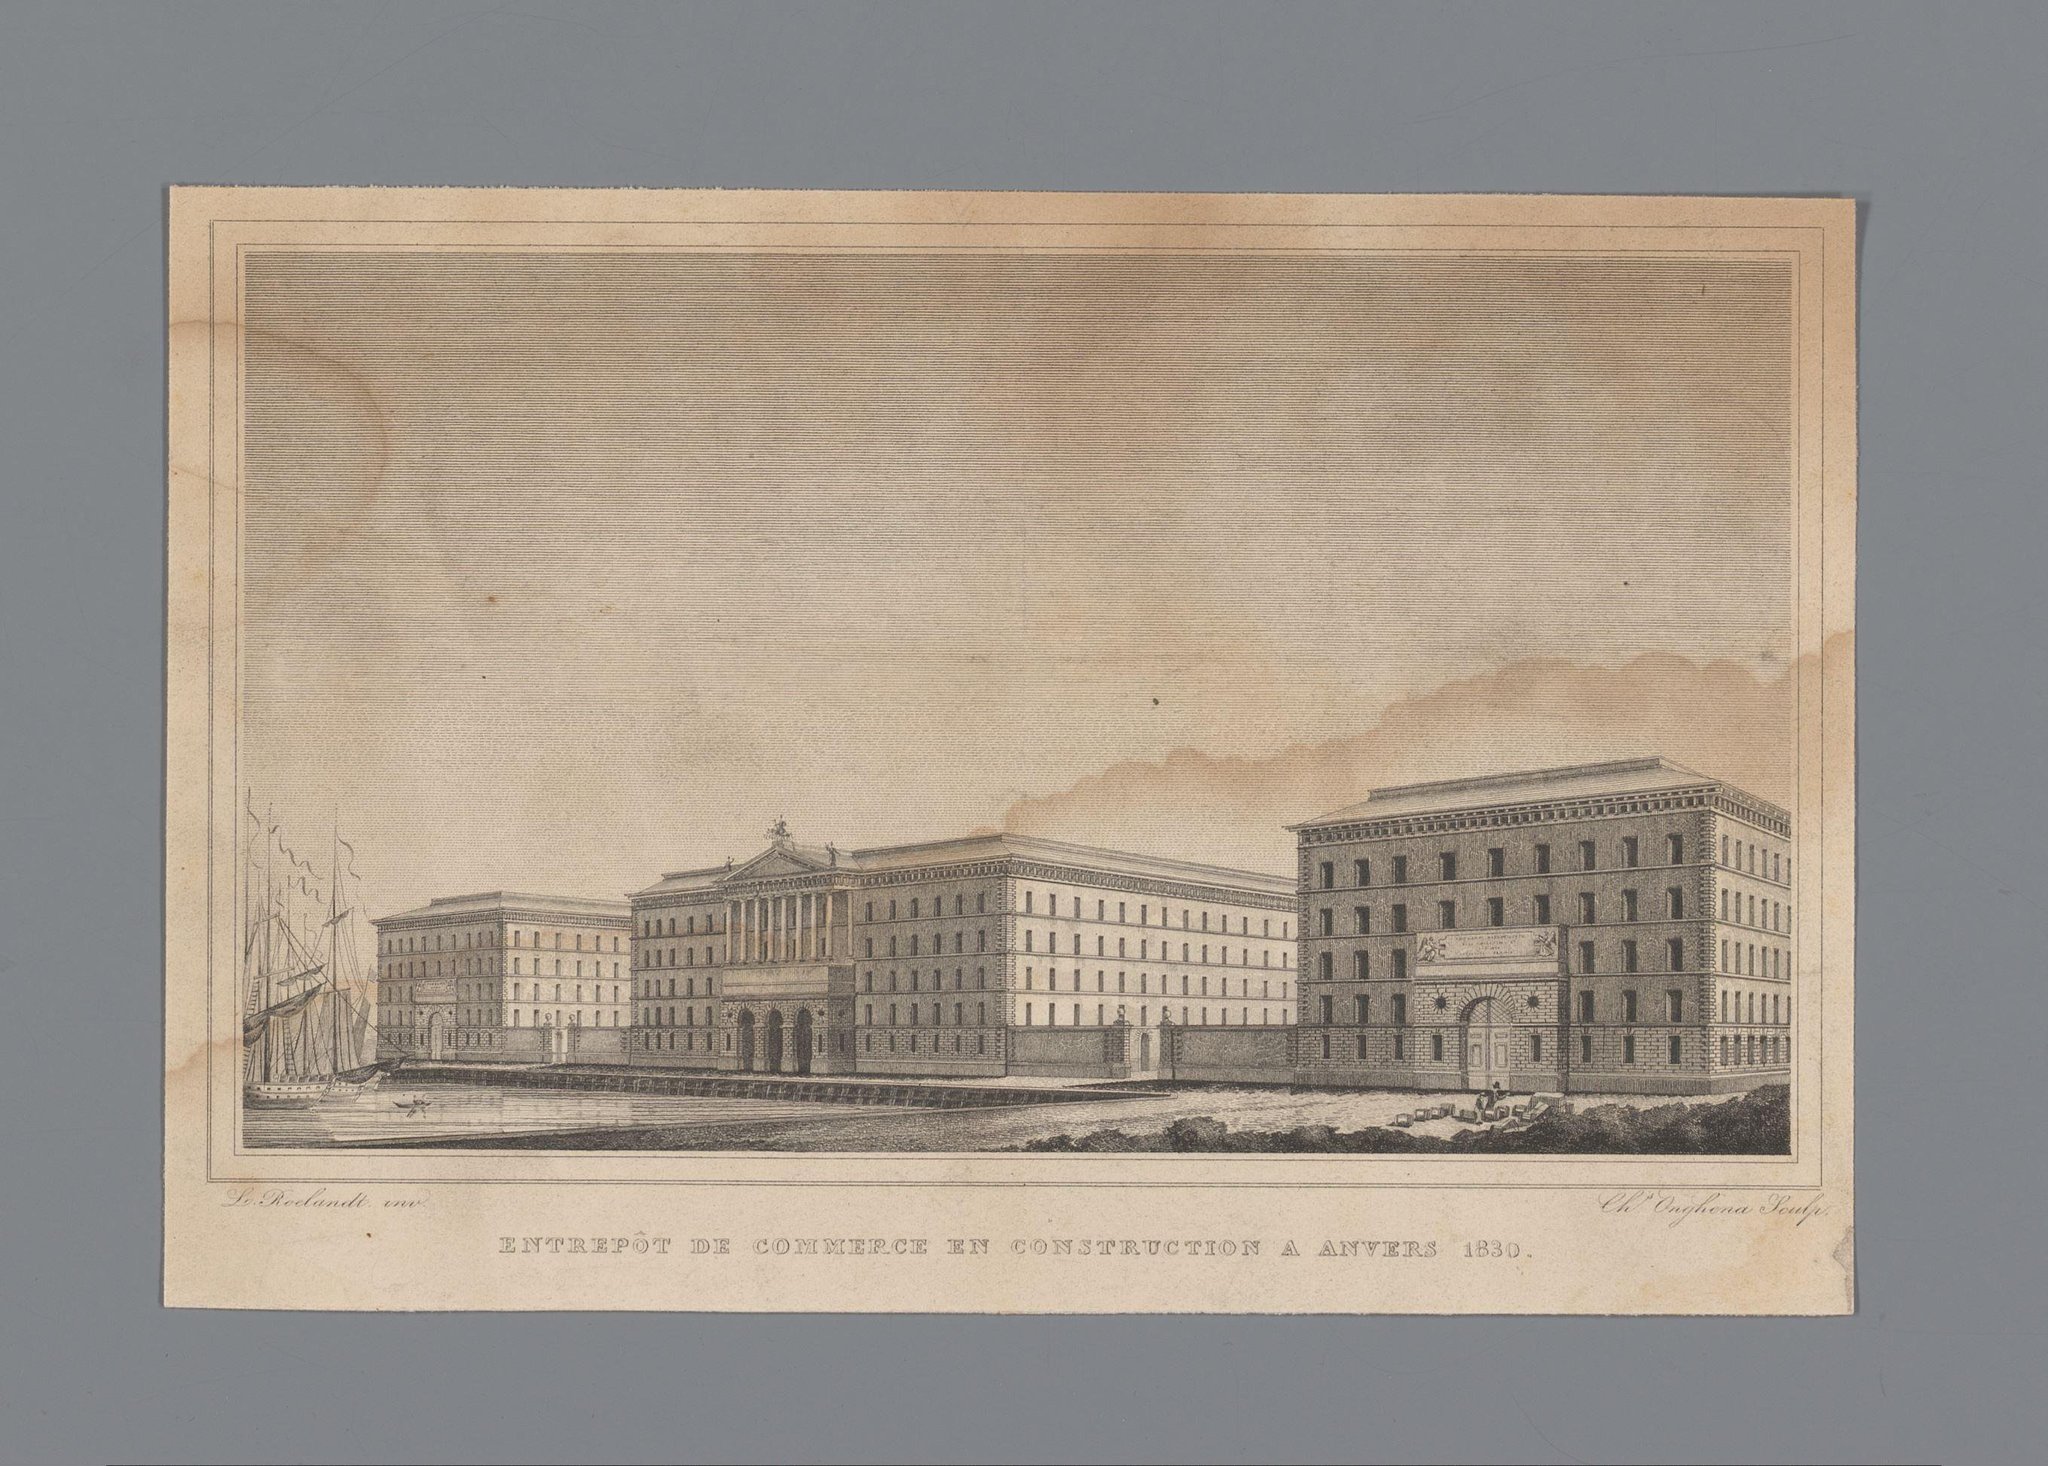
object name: print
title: Entrepot van de koophandel te Antwerpen, 1830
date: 1830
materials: paper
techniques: lithograph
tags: city-view, and landscape with man-made constructions, organization of trade and finance, antwerp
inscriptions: date